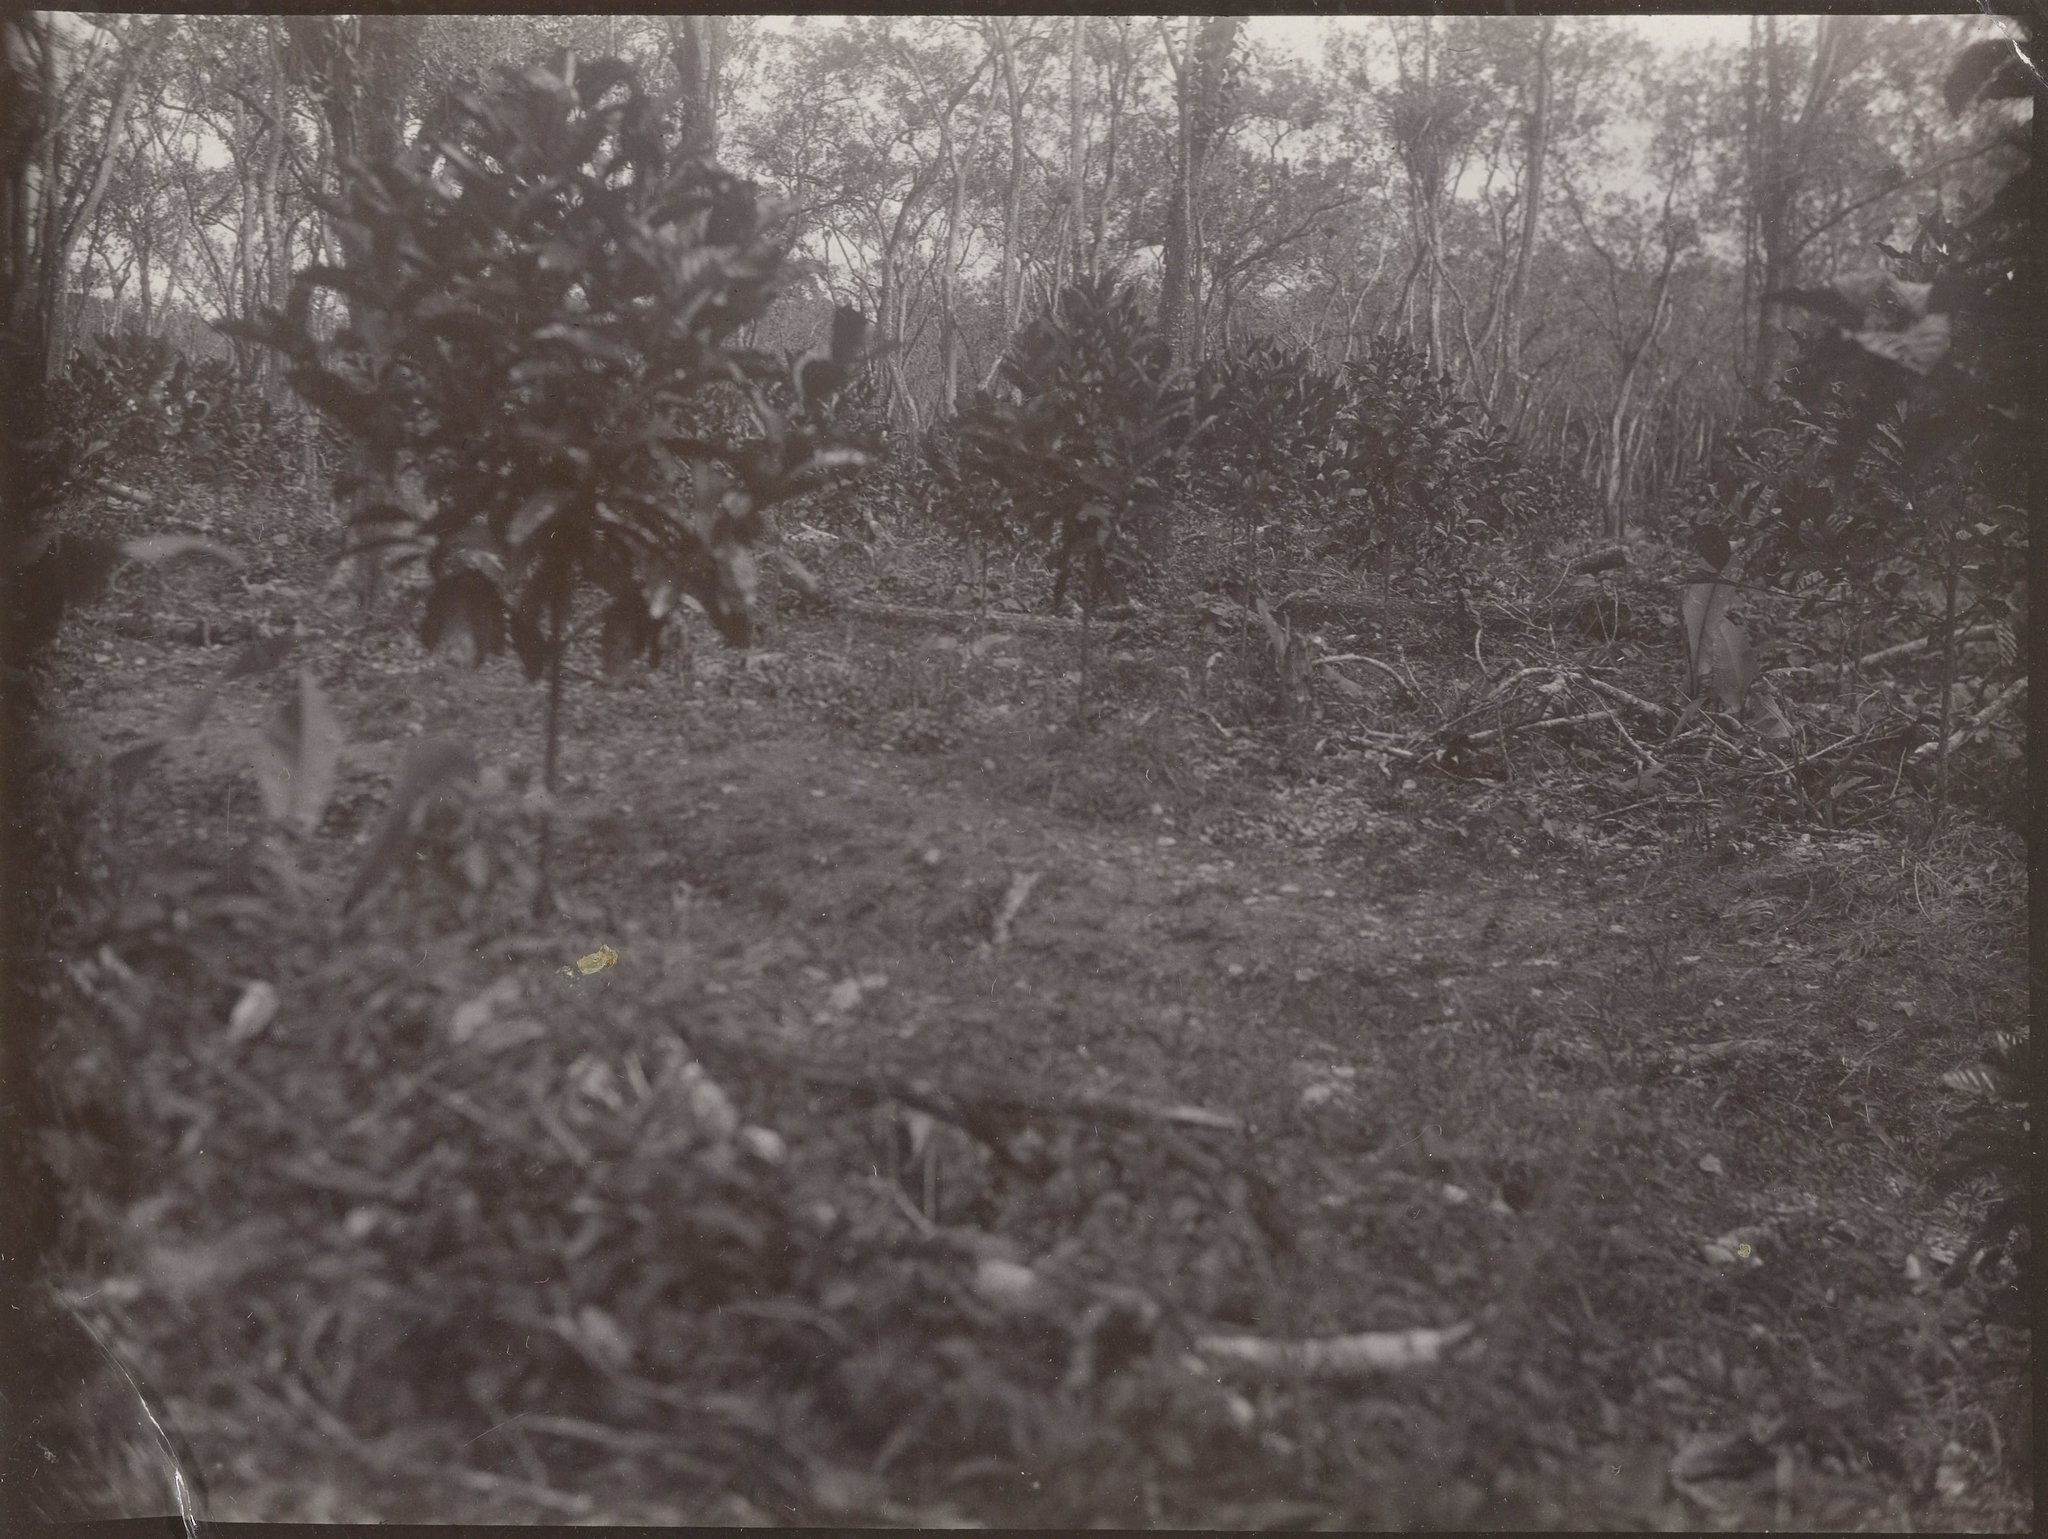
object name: photograph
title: Plantage Accaribo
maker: theodoor brouwers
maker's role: amateurfotograaf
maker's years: 1874-1932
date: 1911-1932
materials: photographic support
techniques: photography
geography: suriname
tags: theodoor brouwers, suriname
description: In de periode 1911-1932 woonde op plantage Accaribo in Suriname de familie Brouwers van wie de foto's afkomstig zijn. Rond 1910 vond Theodoor Brouwers werk op plantage Accaribo. In 1929 werd hij eigenaar van de plantage.